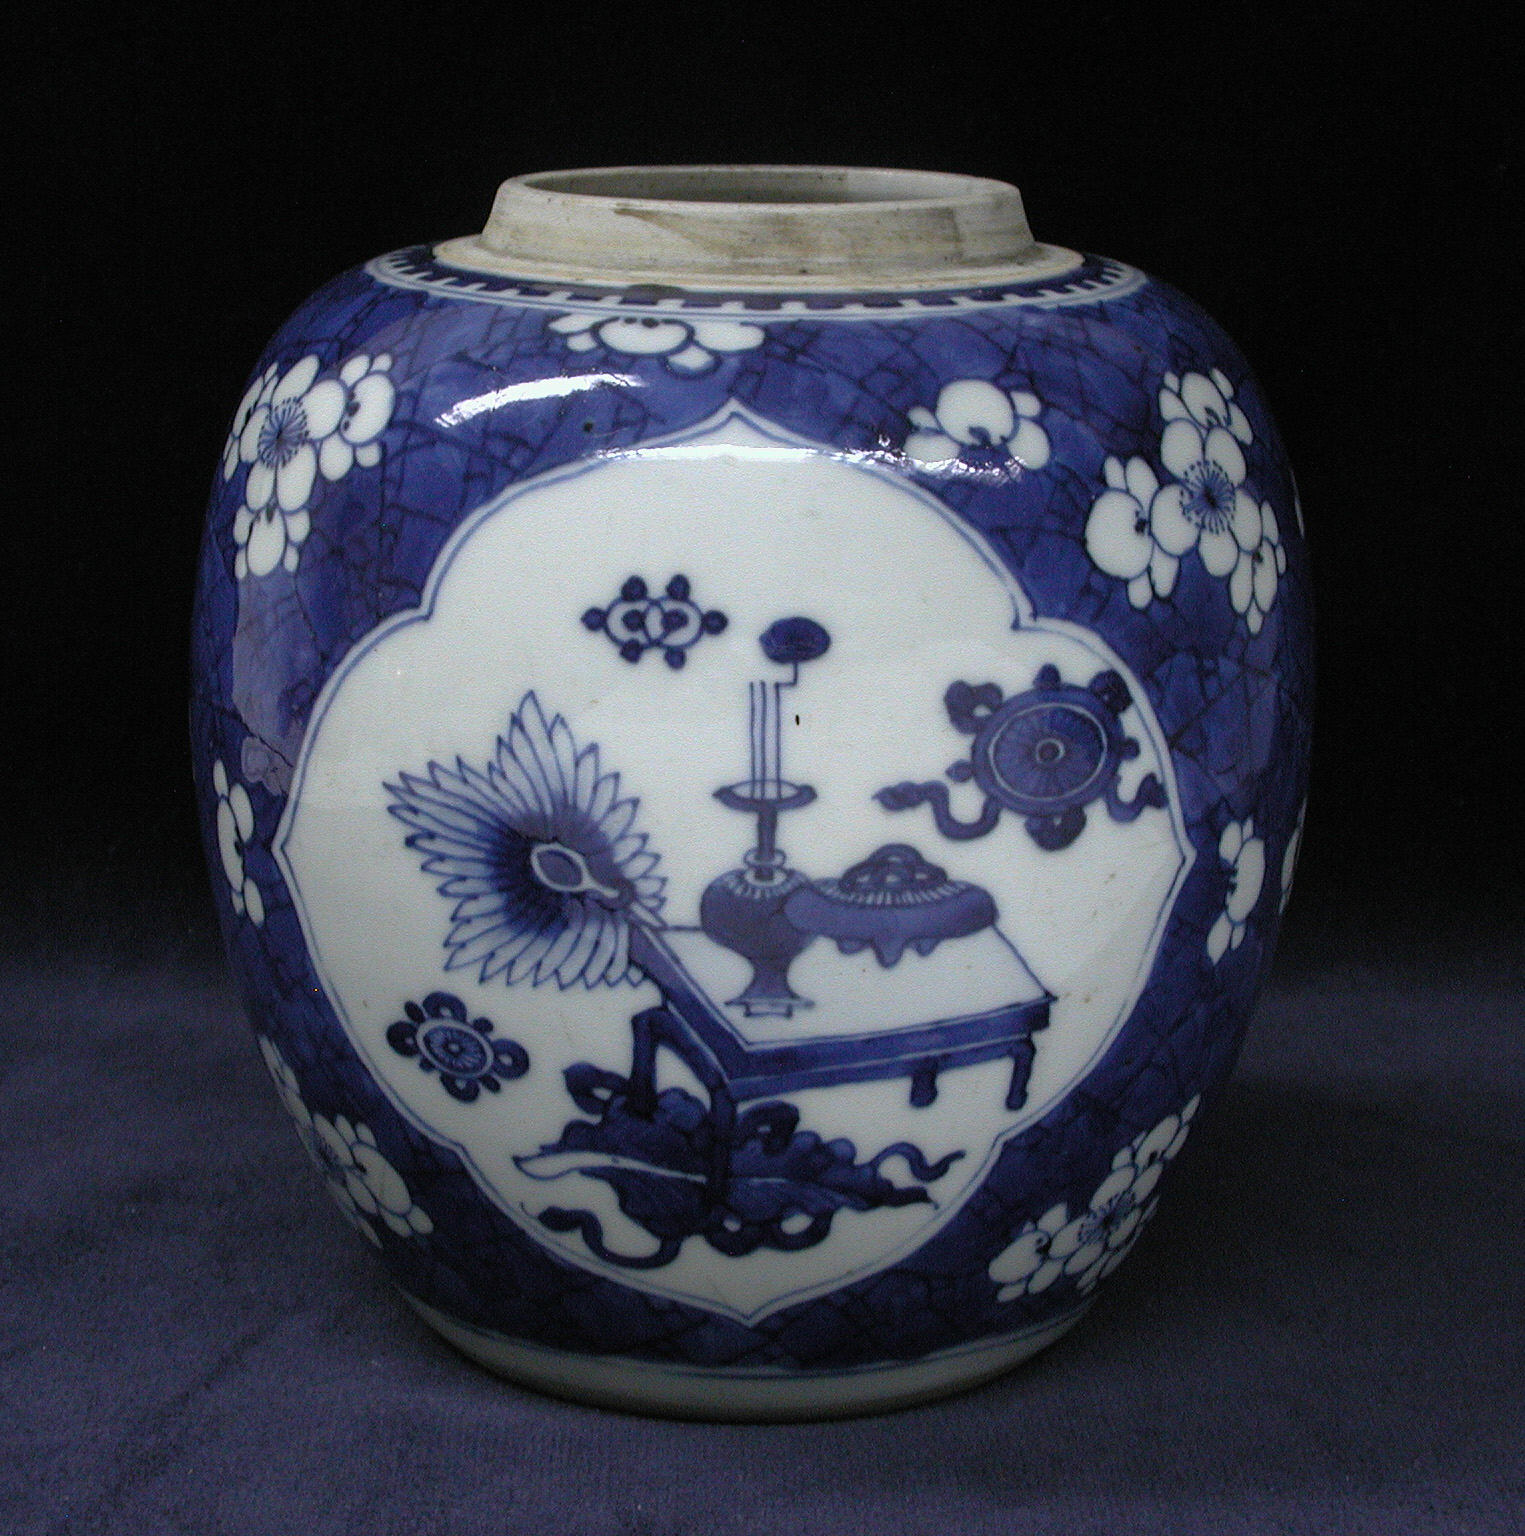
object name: jar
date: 1700-1710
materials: porcelain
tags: flowers